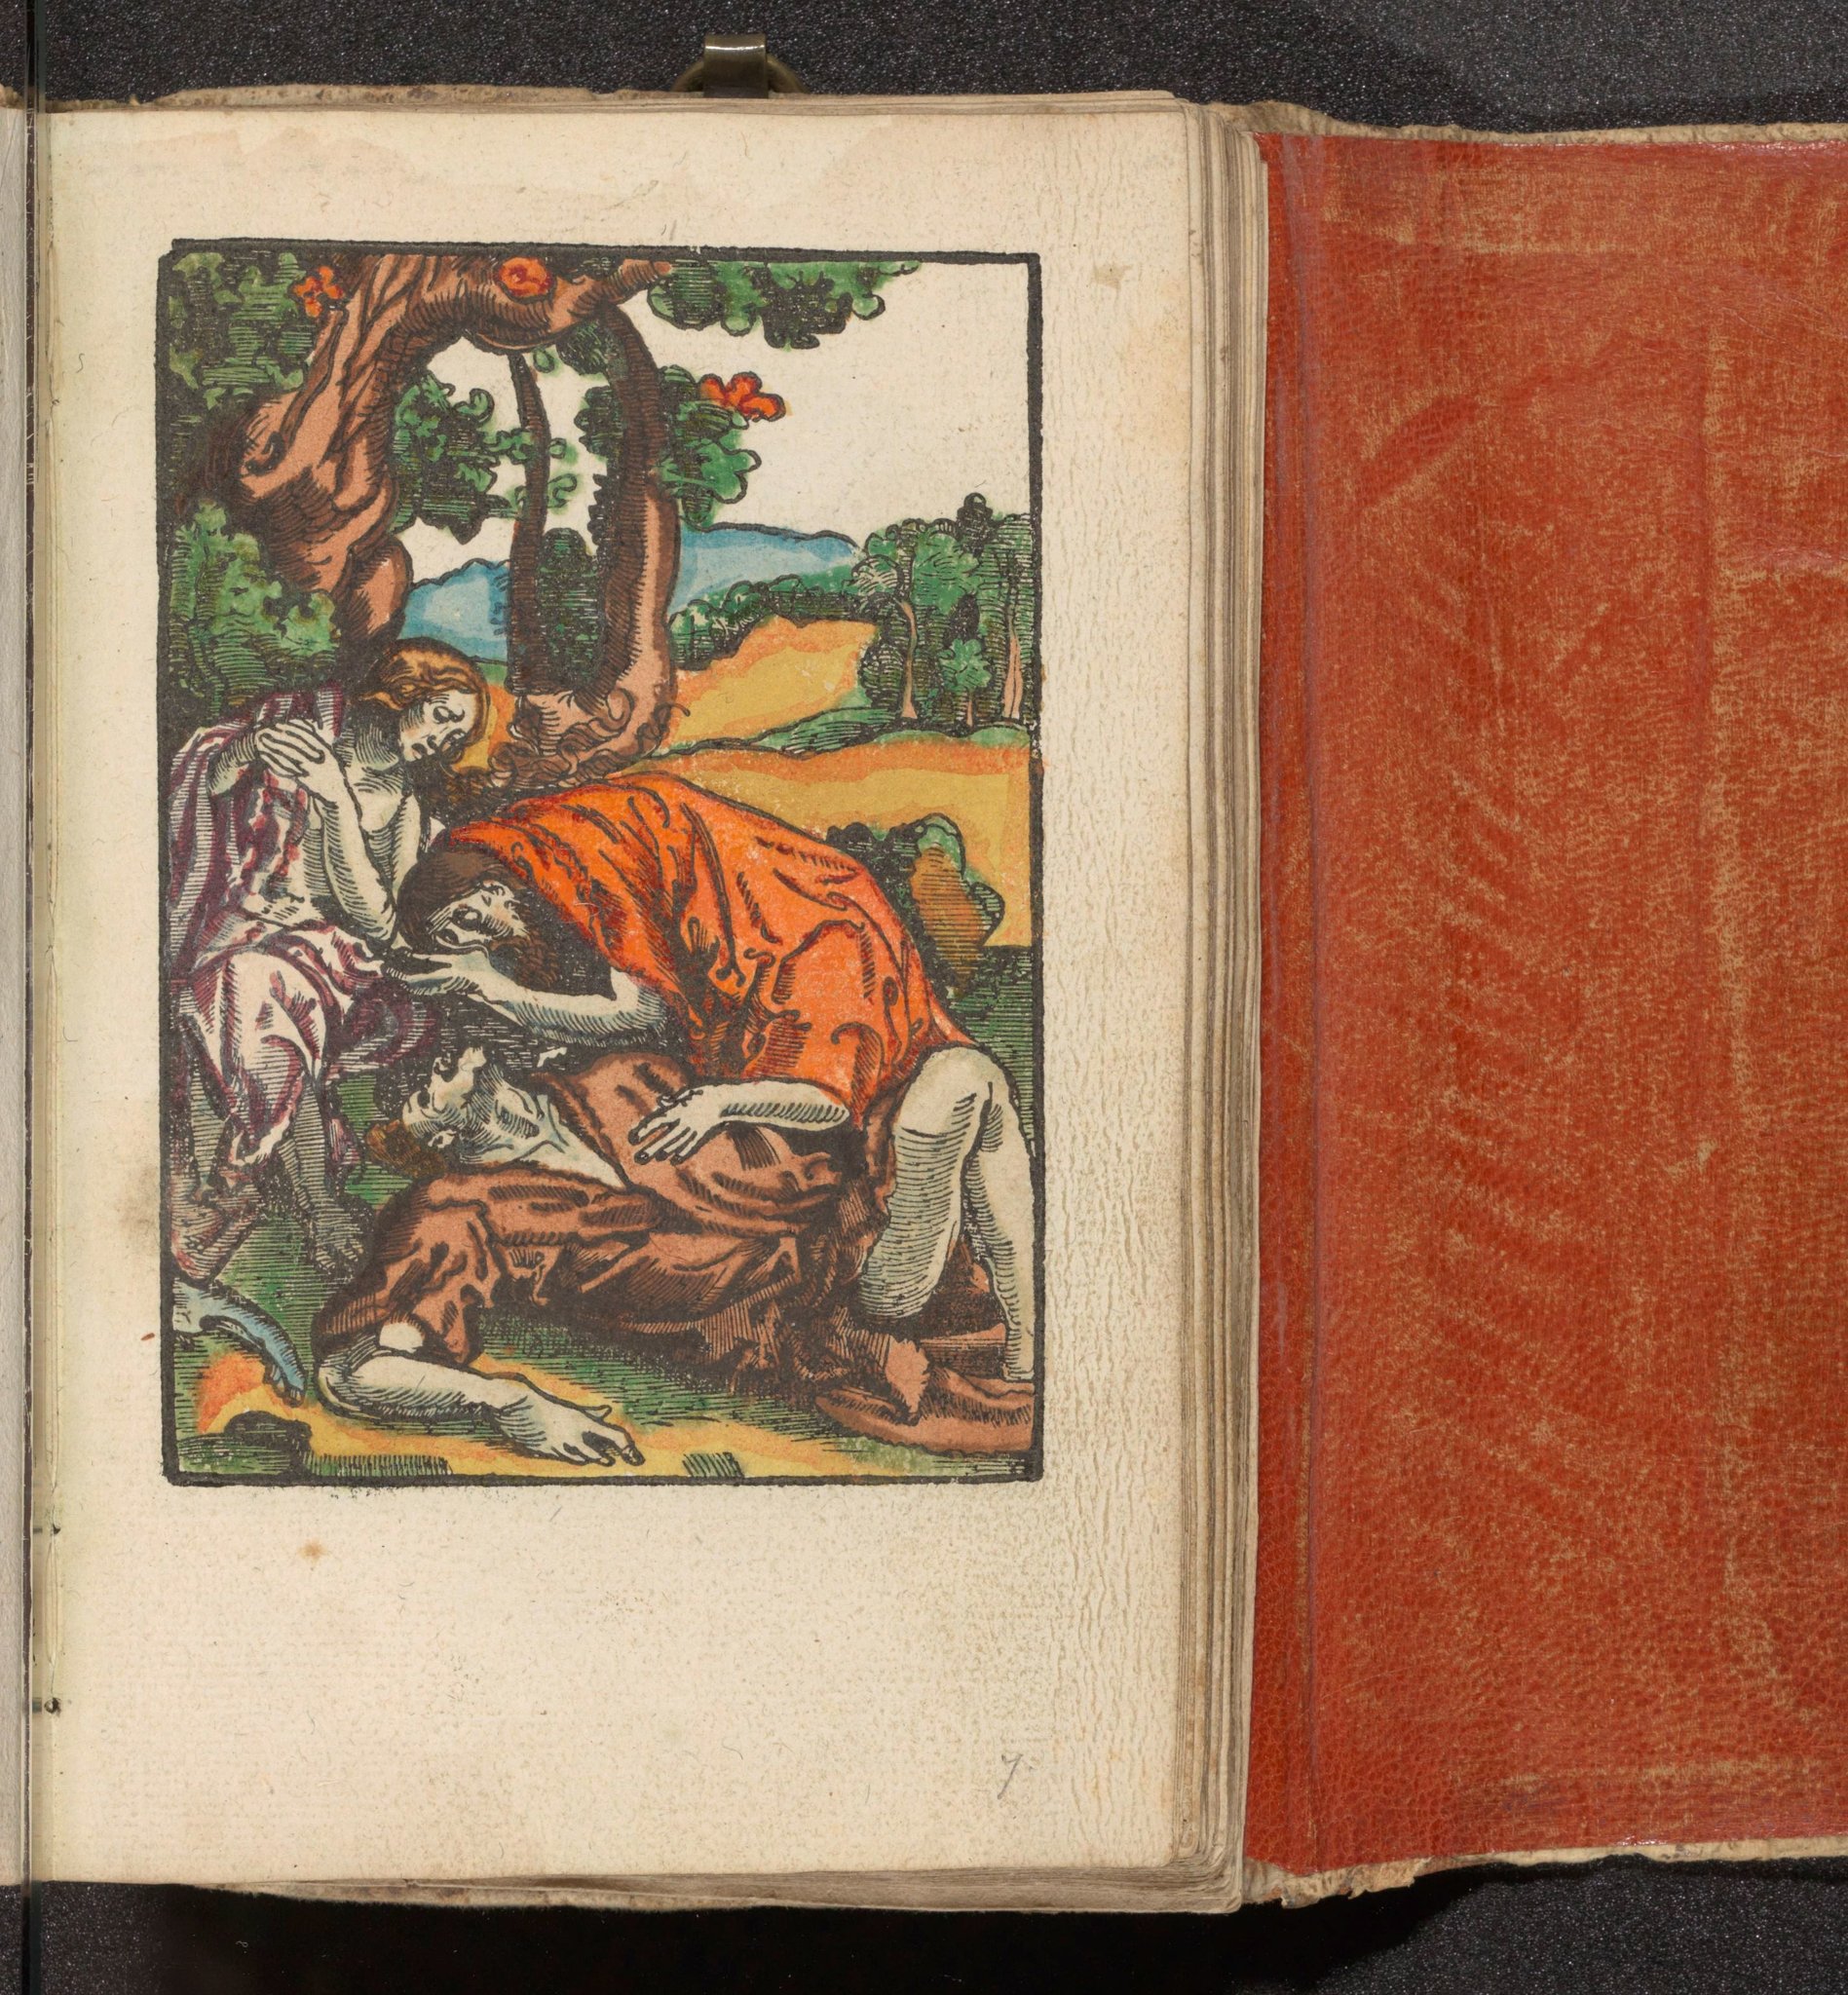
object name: book illustration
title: Stomme Passie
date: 1530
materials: paper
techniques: hand coloring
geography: amsterdam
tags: adam and eve discover the dead body of abel and grieve over it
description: Adam en Eva vinden hun zoon Abel, die is gedood door zijn broer Kaïn. Zij treuren bij zijn lichaam. Prent maakt deel uit van een boek.